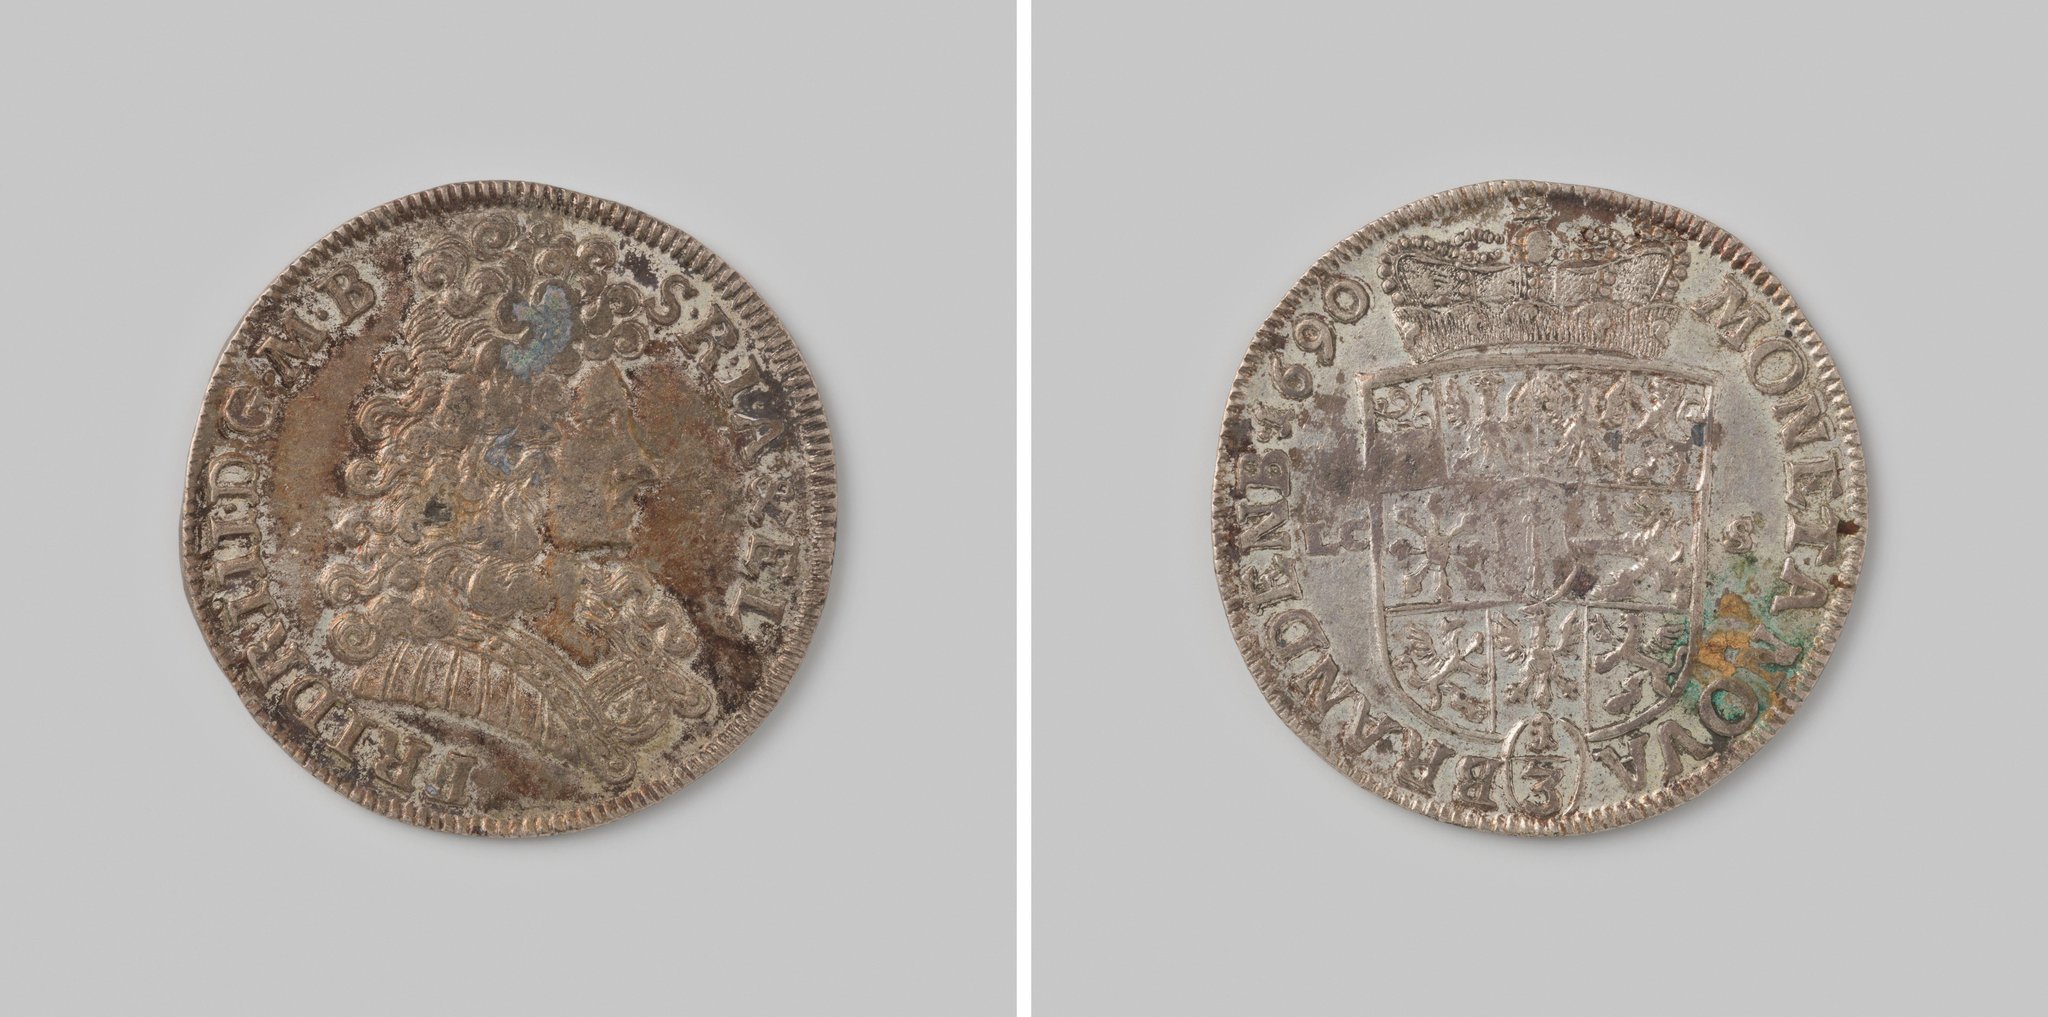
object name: derde taler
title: Derde taler uit Brandenburg van Friedrich III, 1690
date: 1690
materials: silver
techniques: striking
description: Zilveren munt. Voorzijde: borstbeeld naar rechts. Keerzijde: tussen letters L,C en S samengesteld versierd wapenschild, waarop keurvorstenhoed. Rondom hoed jaartal. Onder wapenschild waarde-aanduidng. Gladde rand.